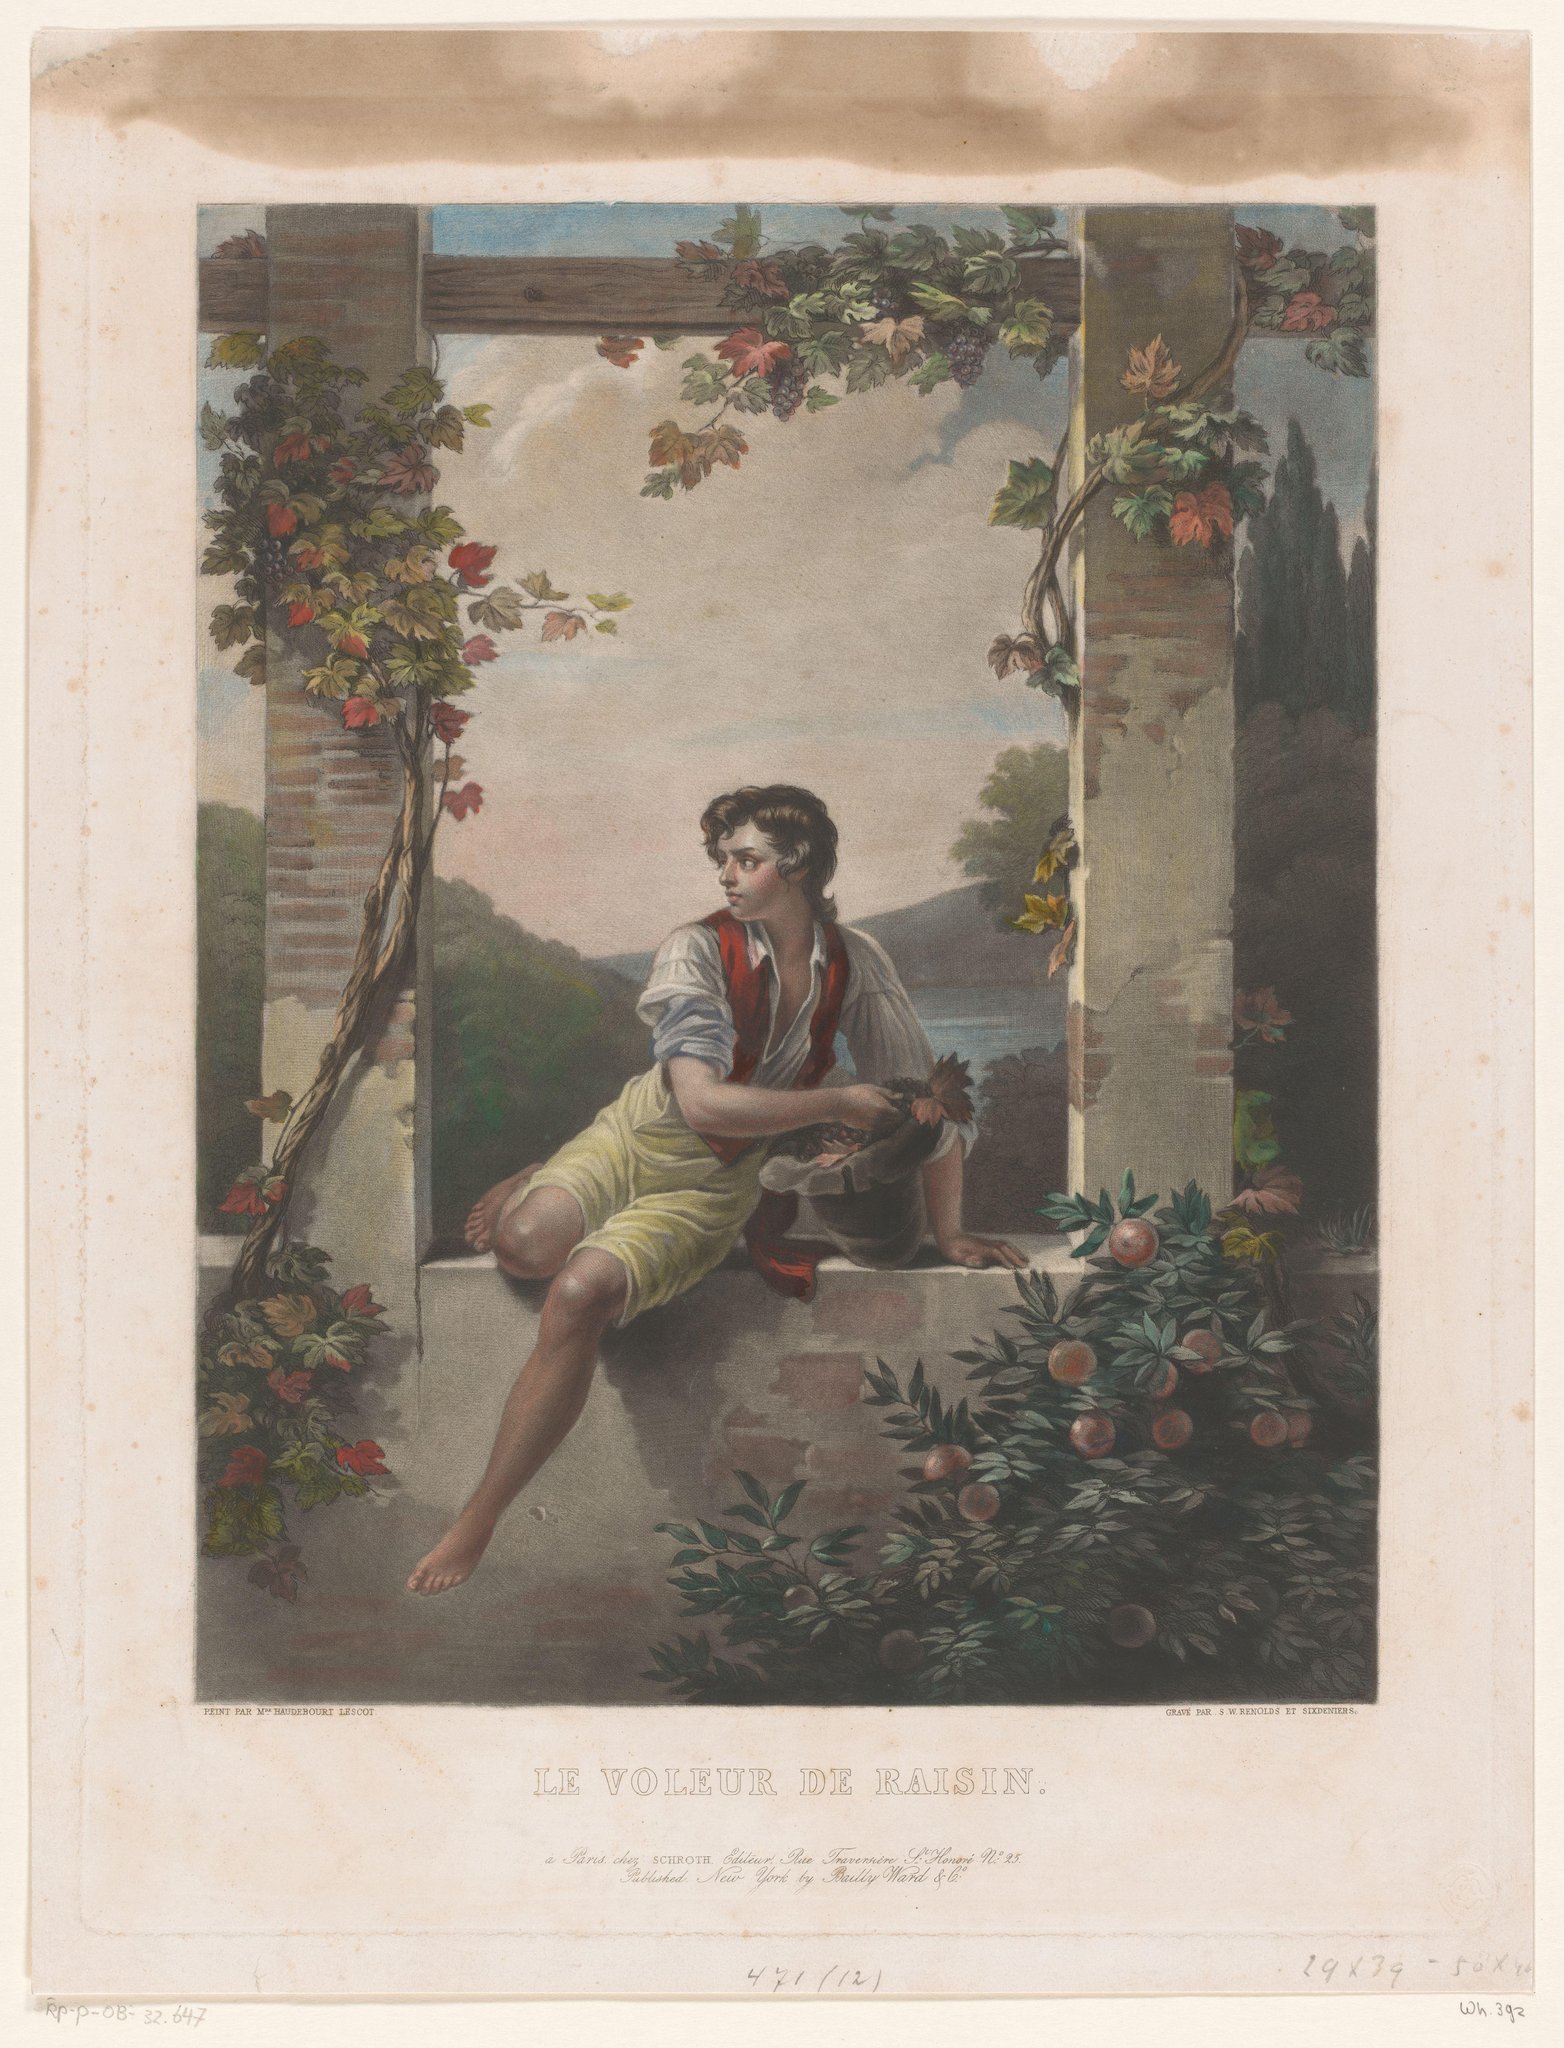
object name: print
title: Jongen met hoed vol druiven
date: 1825-1836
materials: paper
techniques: hand coloring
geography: london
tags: thief, bunch of grapes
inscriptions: collector's mark: Lugt 2228, check stamp: Lugt 634b